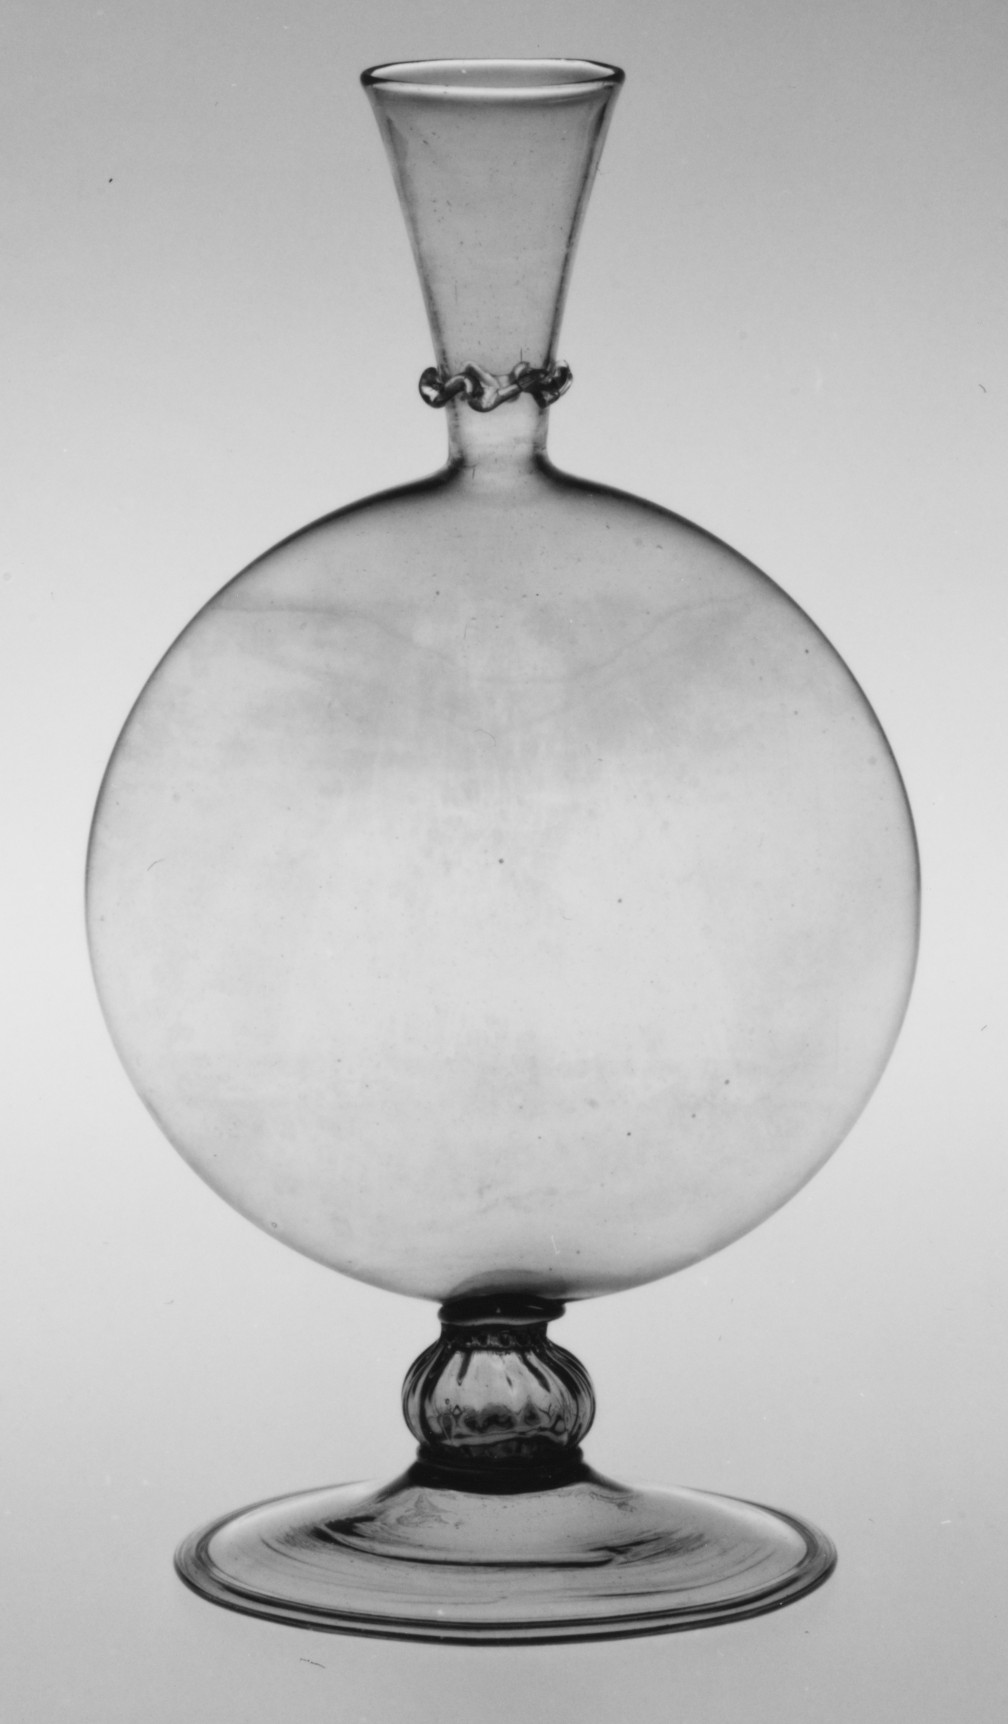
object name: vase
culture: italian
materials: glass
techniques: glassblowing, molding, tinting